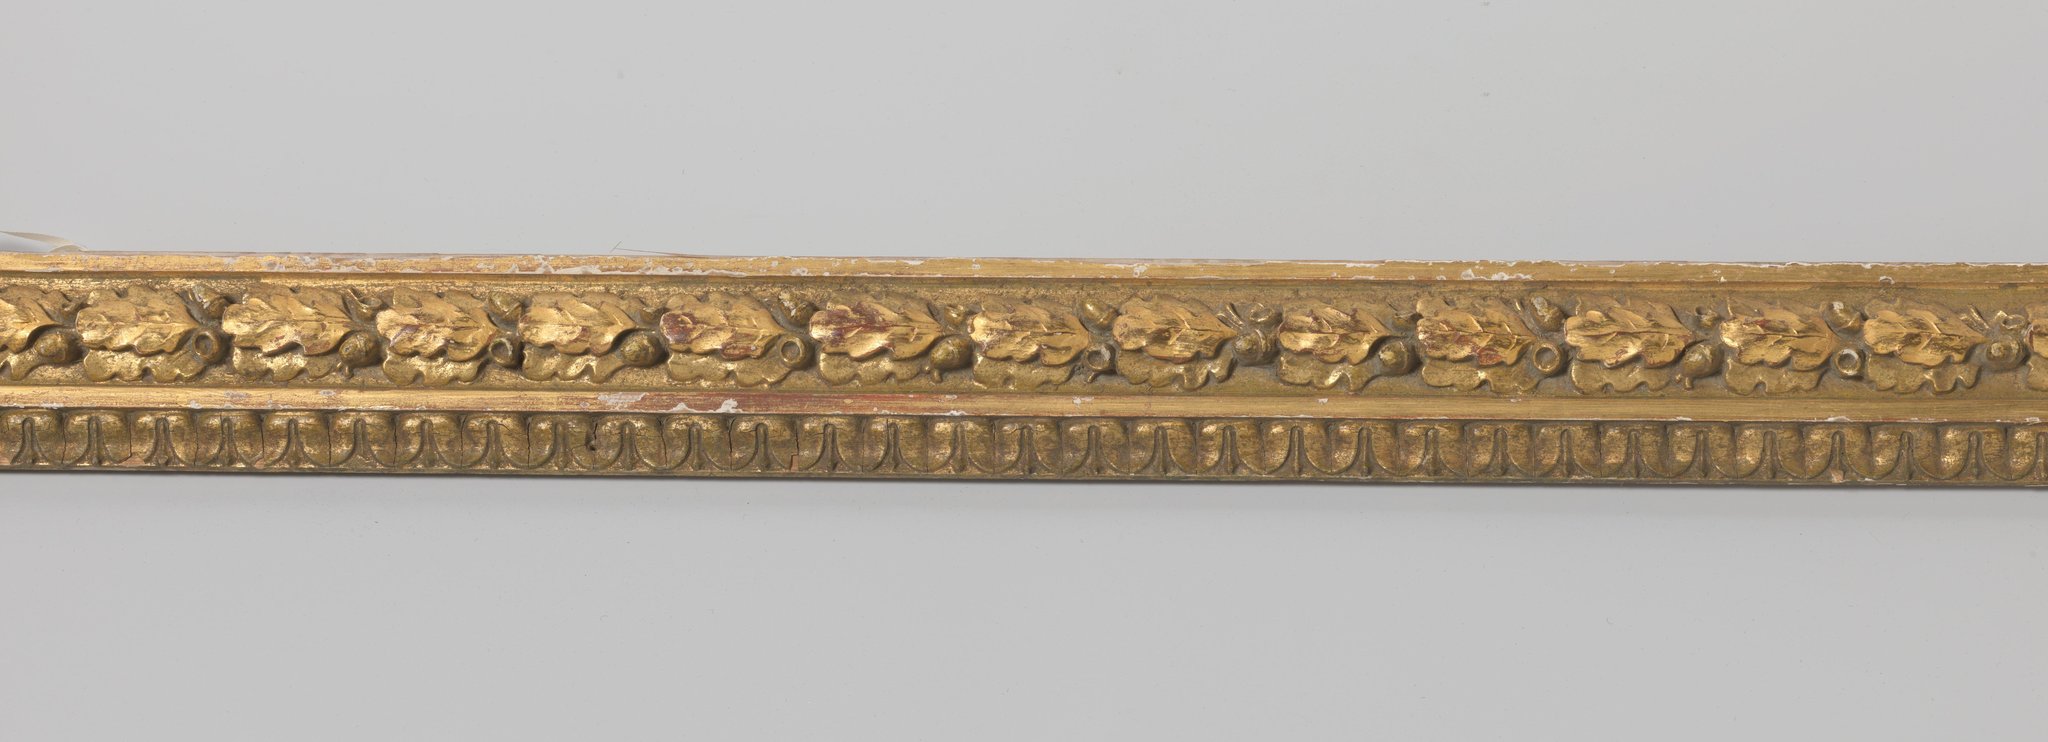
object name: frame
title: Lijstfragment: vergulde lijst met pâte-ornamenten, onderregel deel 1.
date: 1700-1899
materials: gold leaf, wood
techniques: gilding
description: Vergulde lijst met eikenbladeren met eikeltjes. Lijstdeel, deel van de onder regel. Met achterop geschreven: 'Bottom no.3, facing front window'.